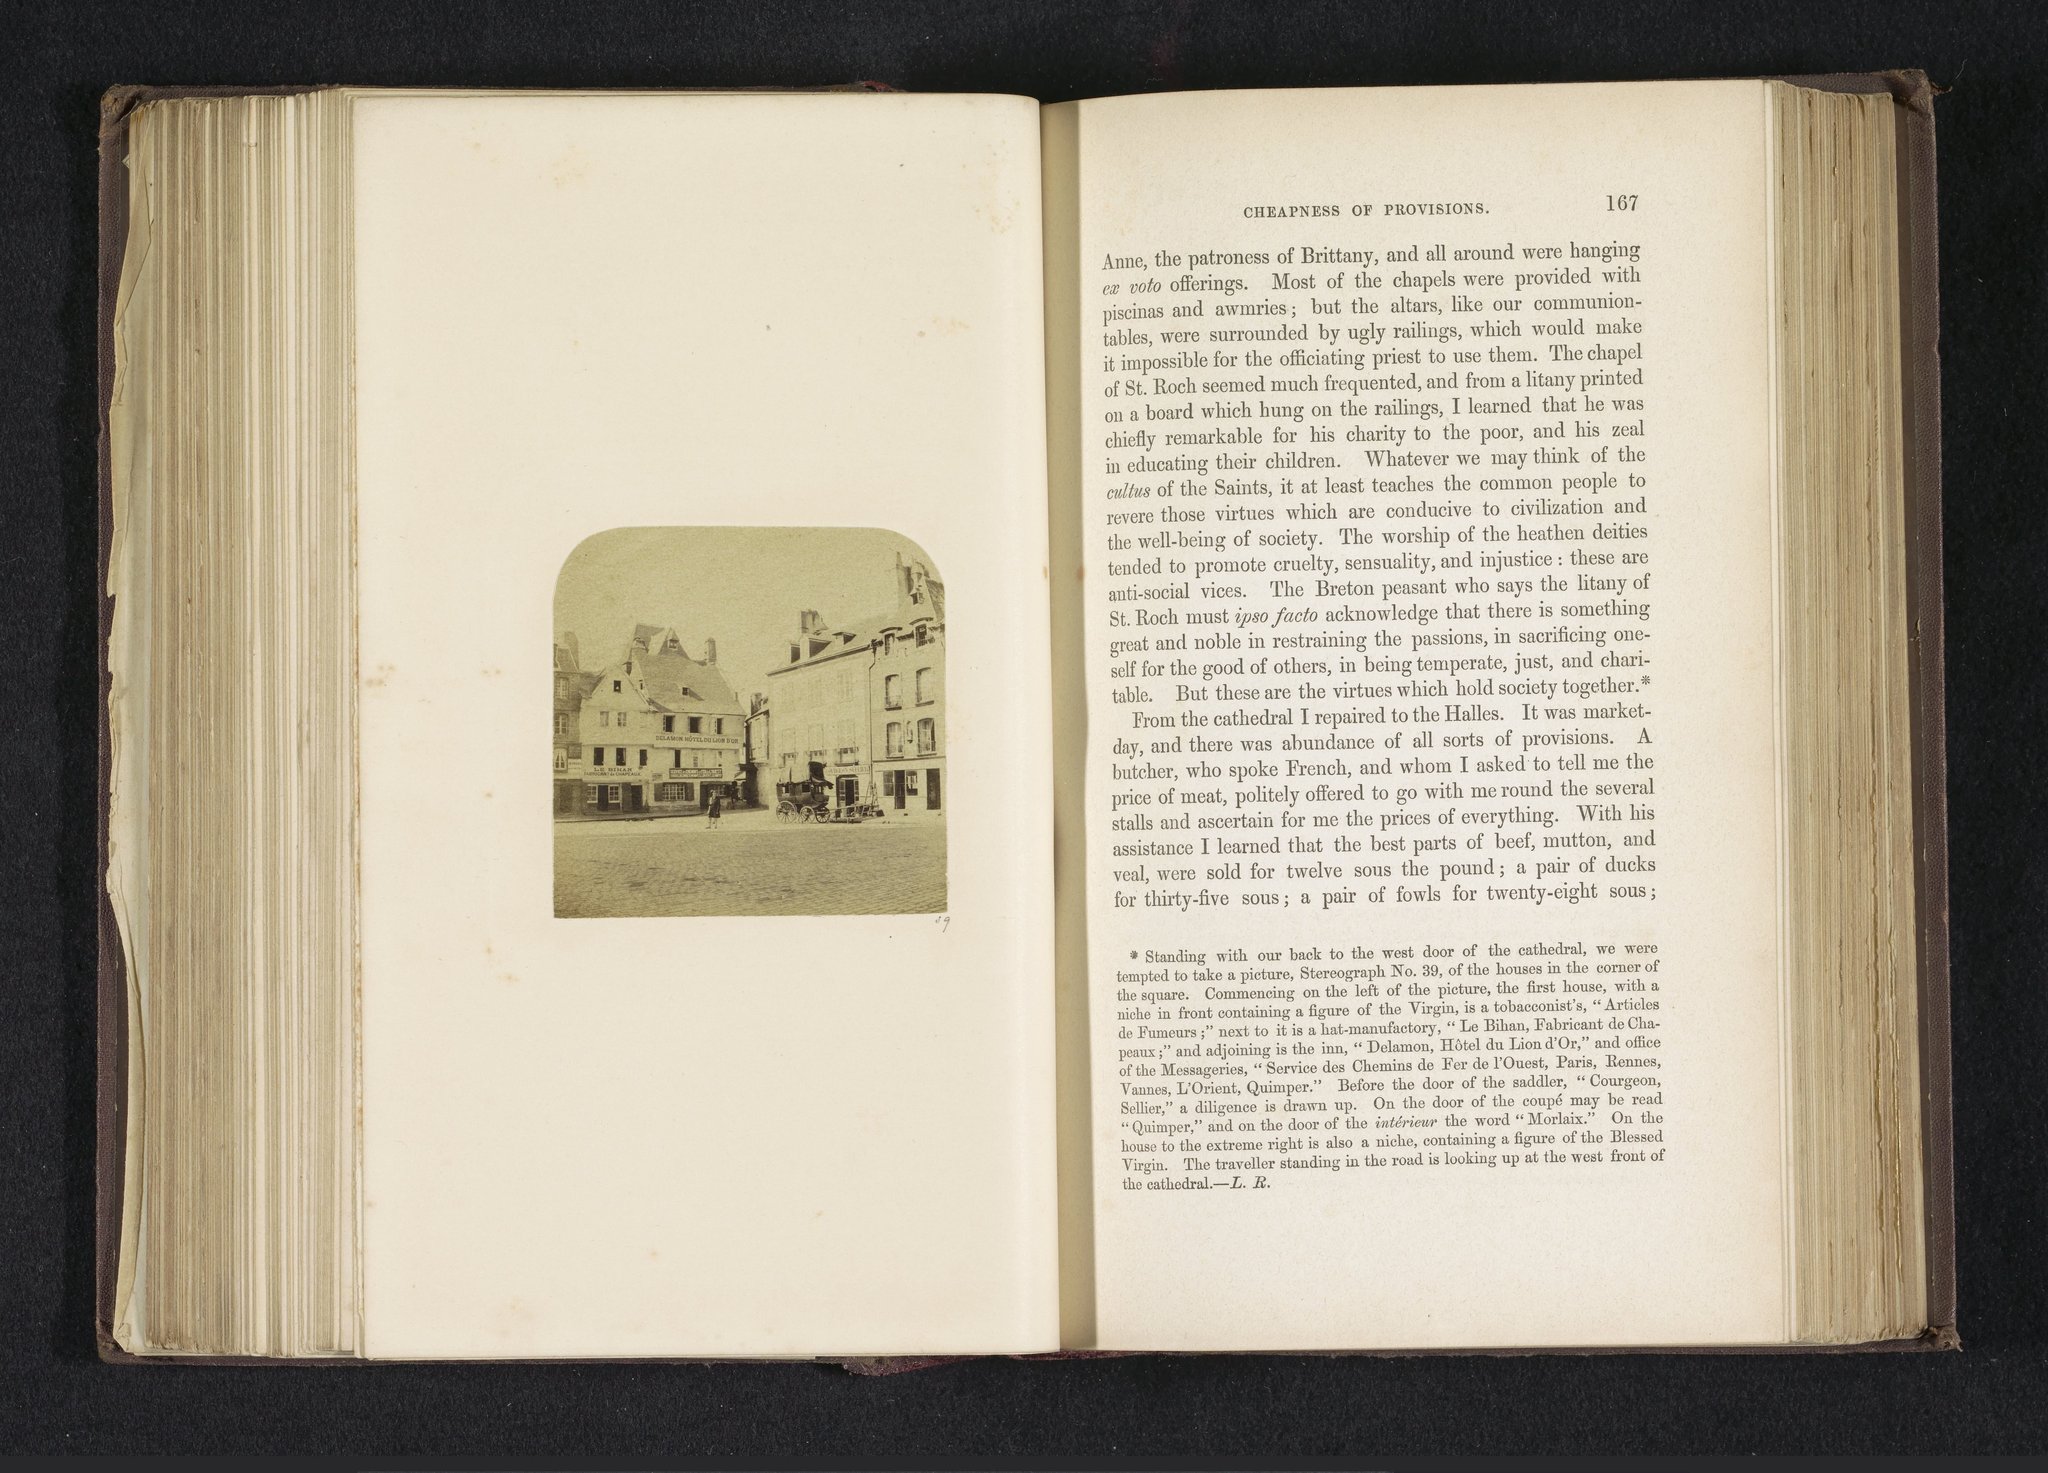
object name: photograph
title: Plein in Quimper met Hôtel du Lion d'Or, winkels en werkplaatsen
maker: taylor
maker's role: fotograaf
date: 1850-1859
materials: photographic support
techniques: albumen print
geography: quimper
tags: four-wheeled, animal-drawn vehicle, e.g.: cab, carriage, coach (+ conveyance for transport of persons), workshop, hotel, hostelry, inn, square, place, circus, etc. (+ city(-scape) with figures, staffage)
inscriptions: number: ‘39’